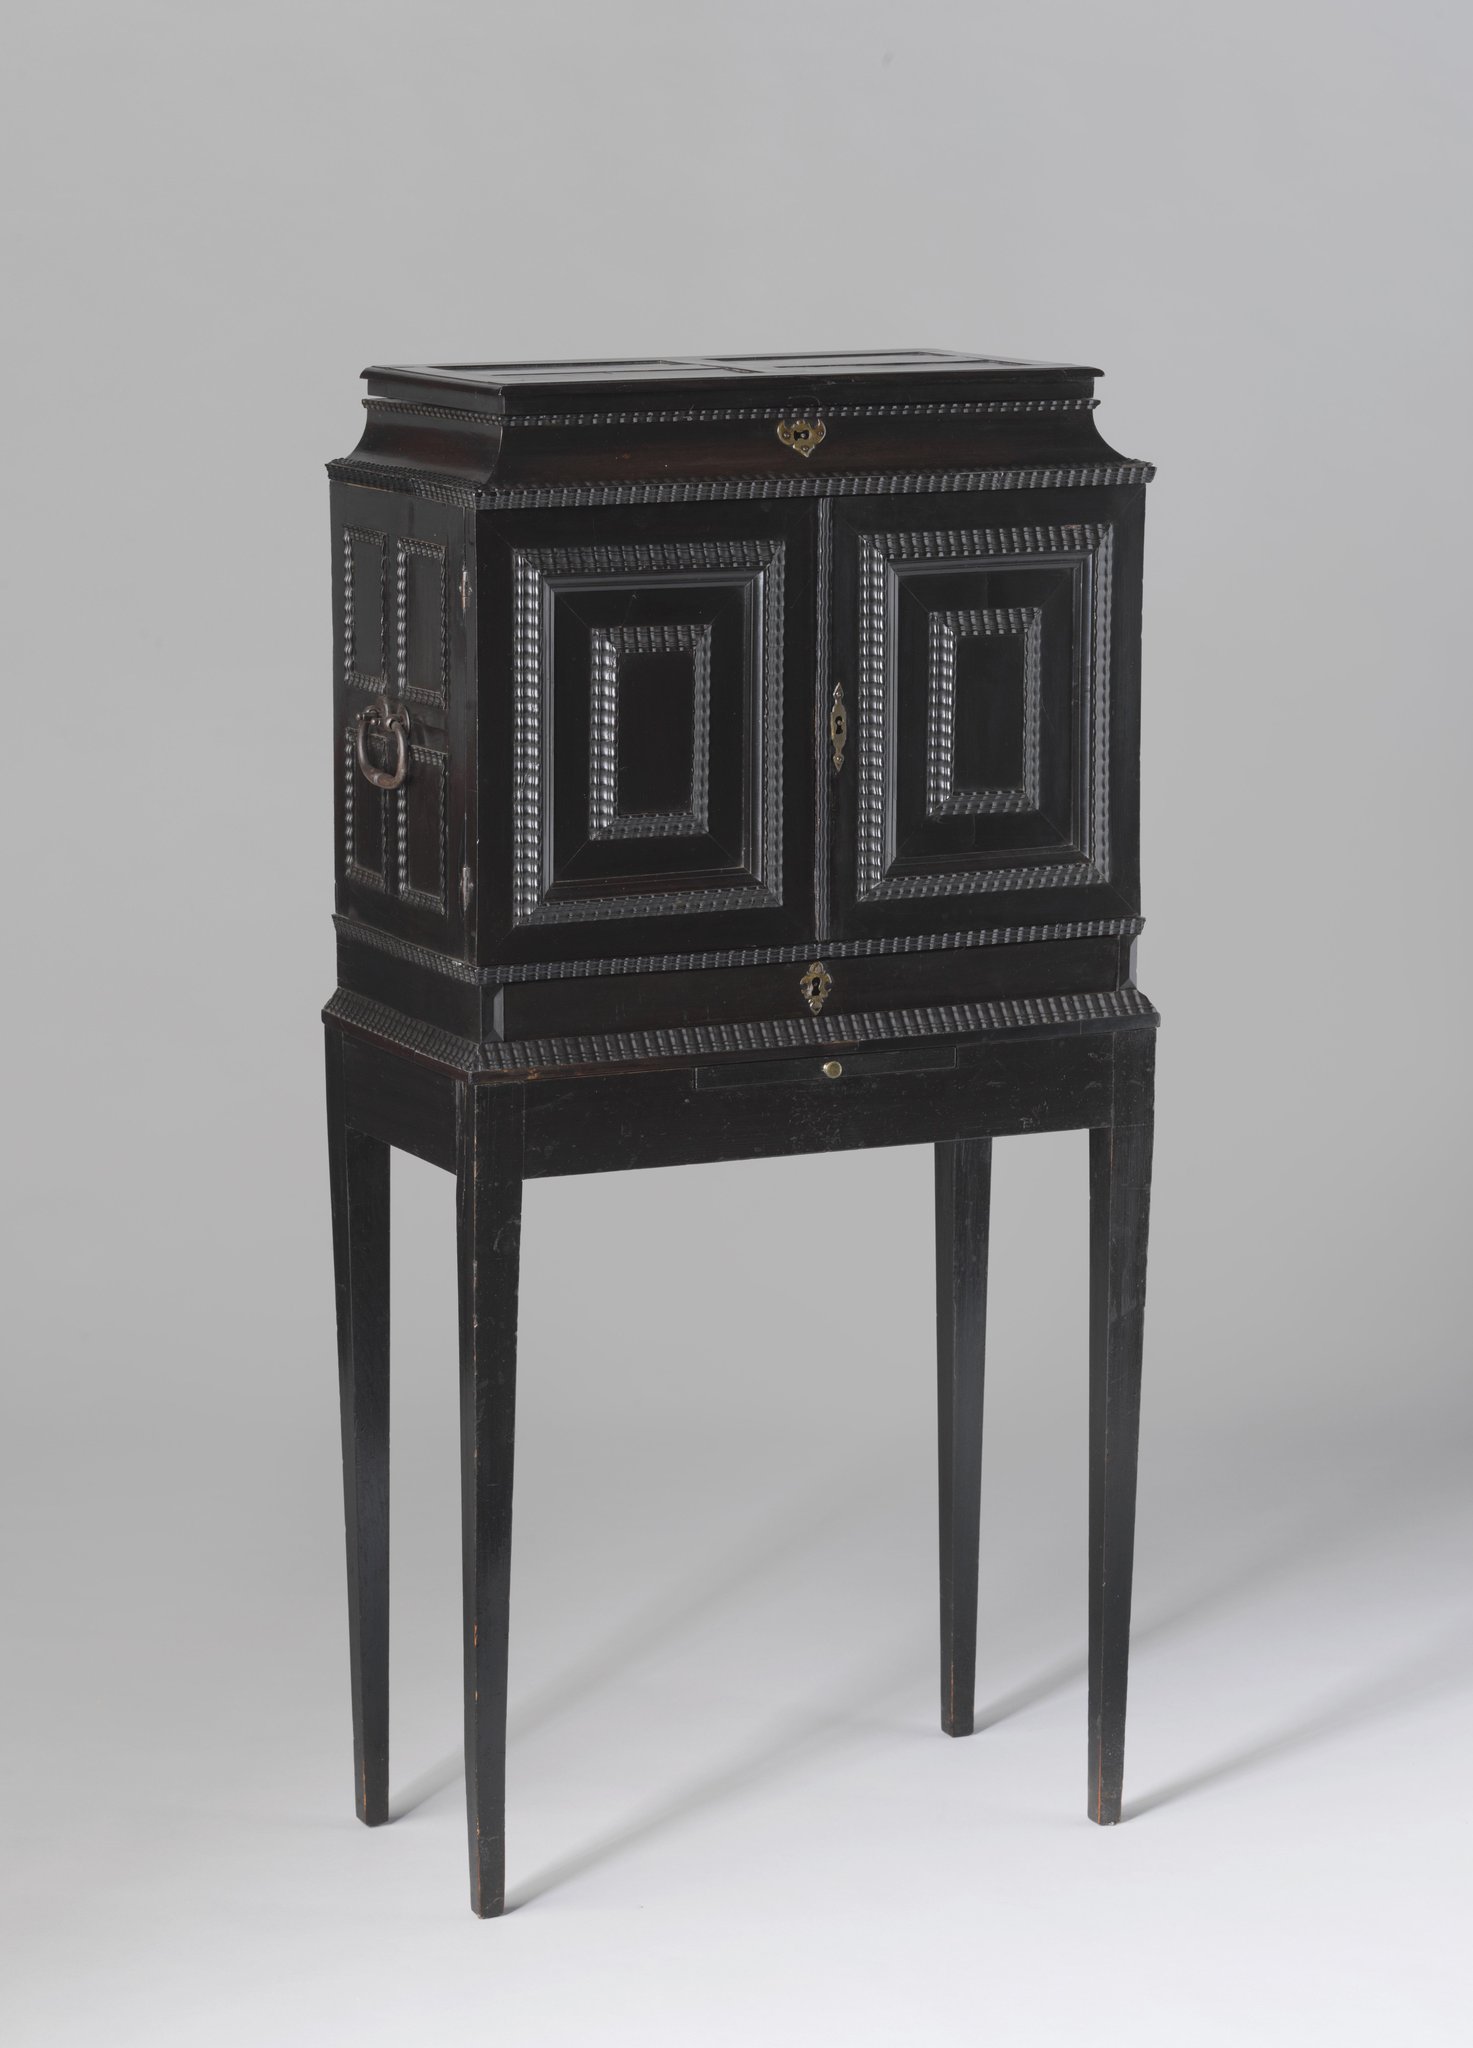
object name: key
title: Sleutel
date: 1400-1950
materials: iron